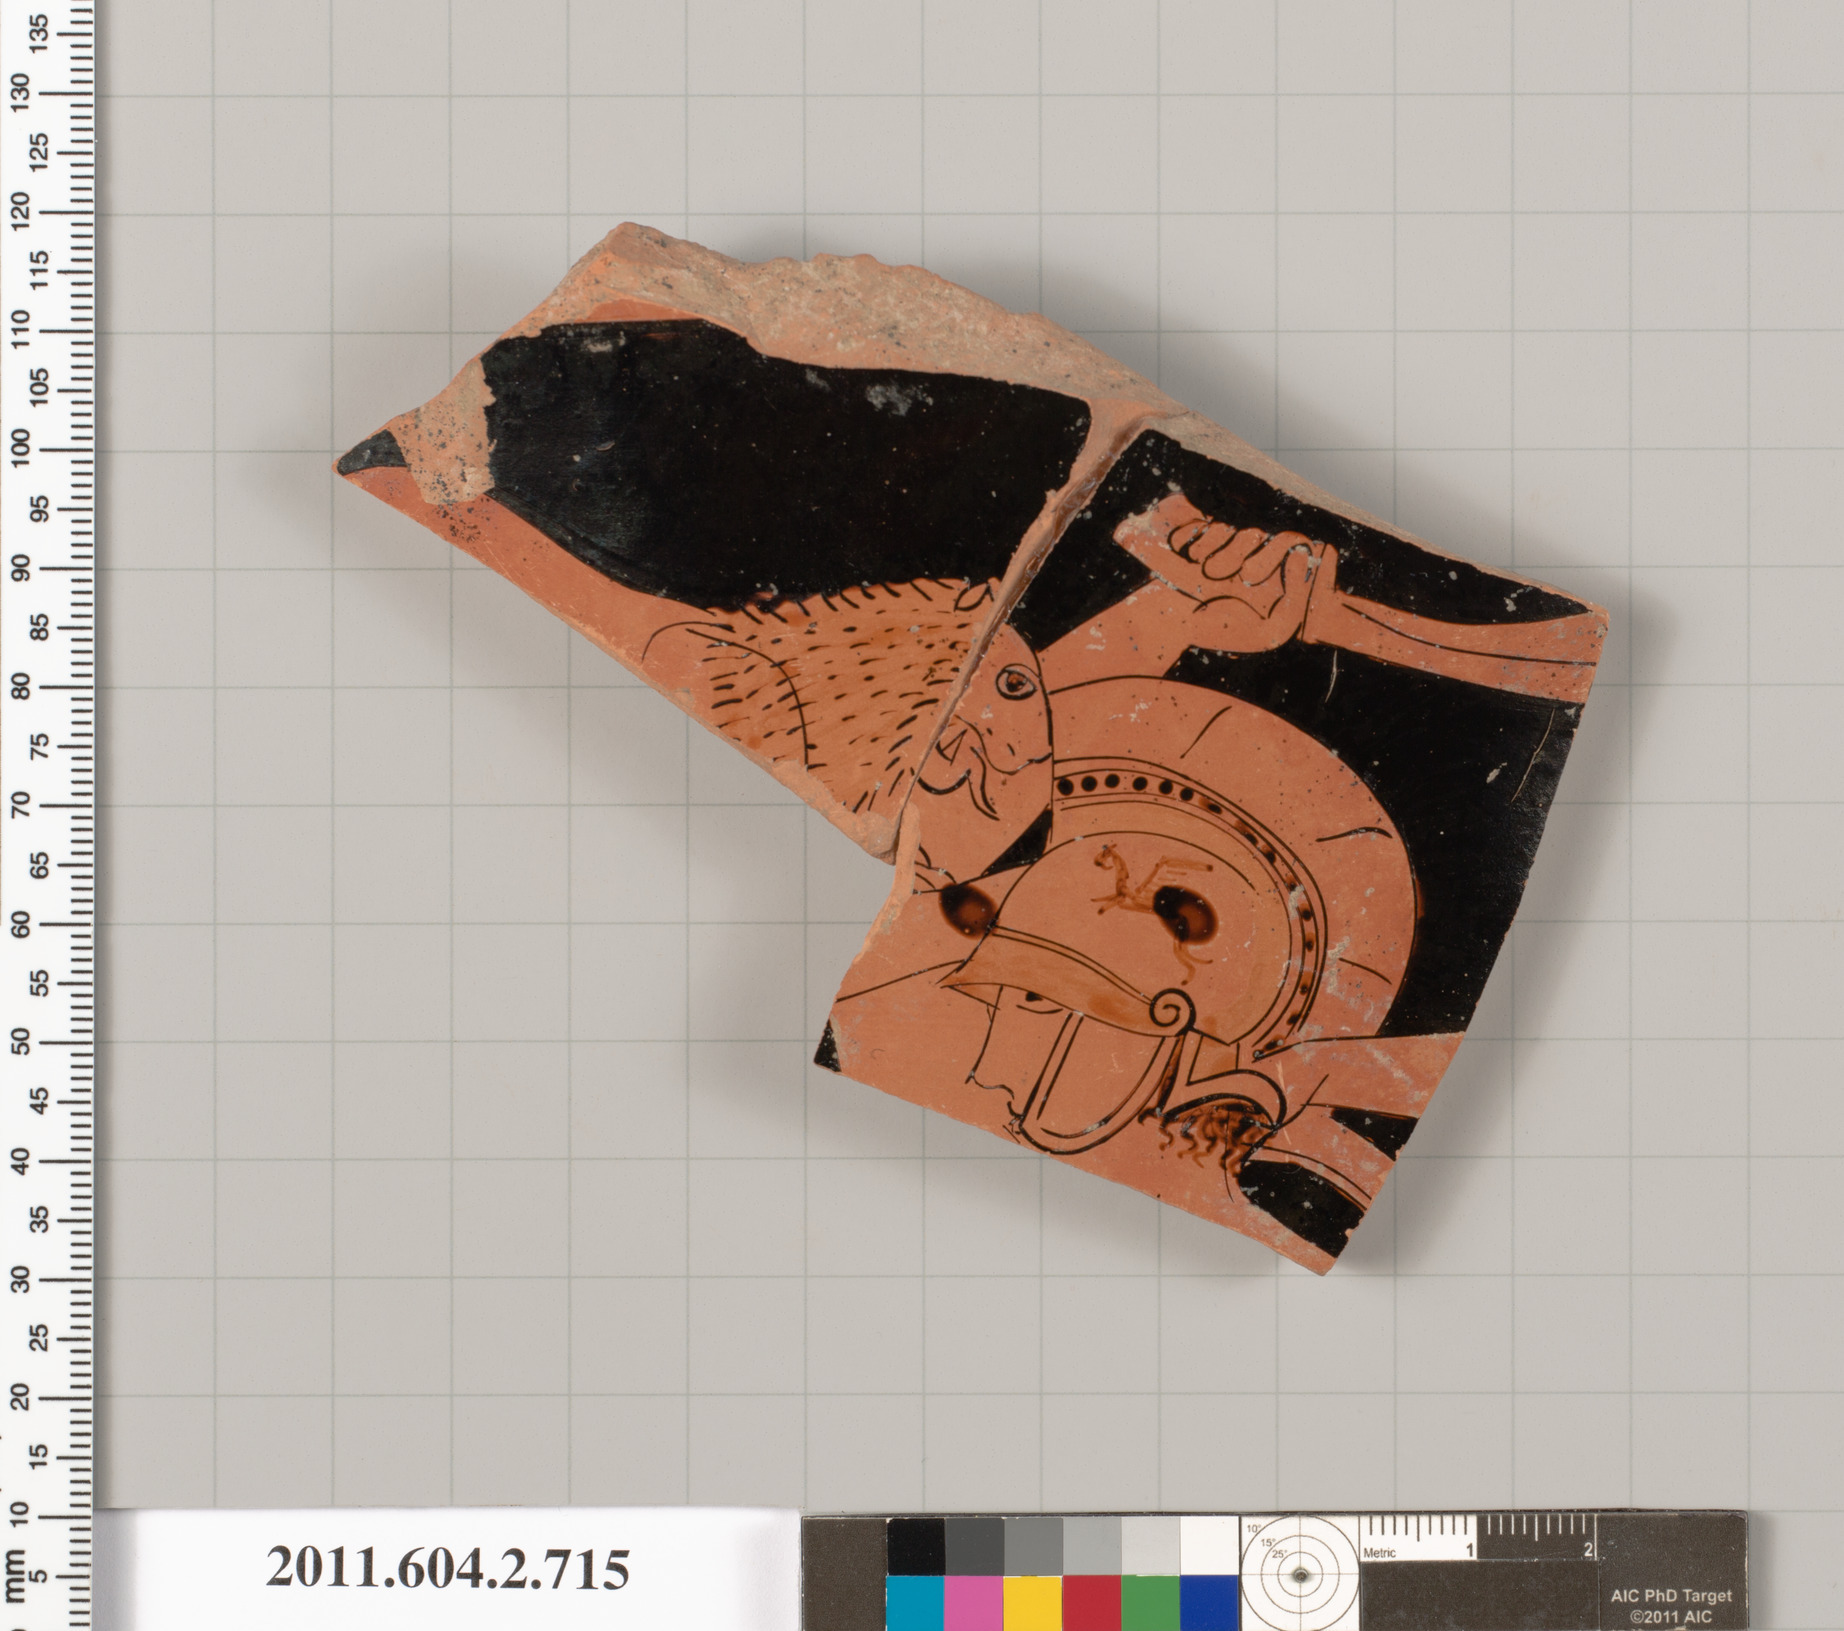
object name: calyx krater fragment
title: Terracotta fragment of a calyx-krater (bowl for mixing wine and water)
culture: greek, attic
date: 460-450 BCE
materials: terracotta